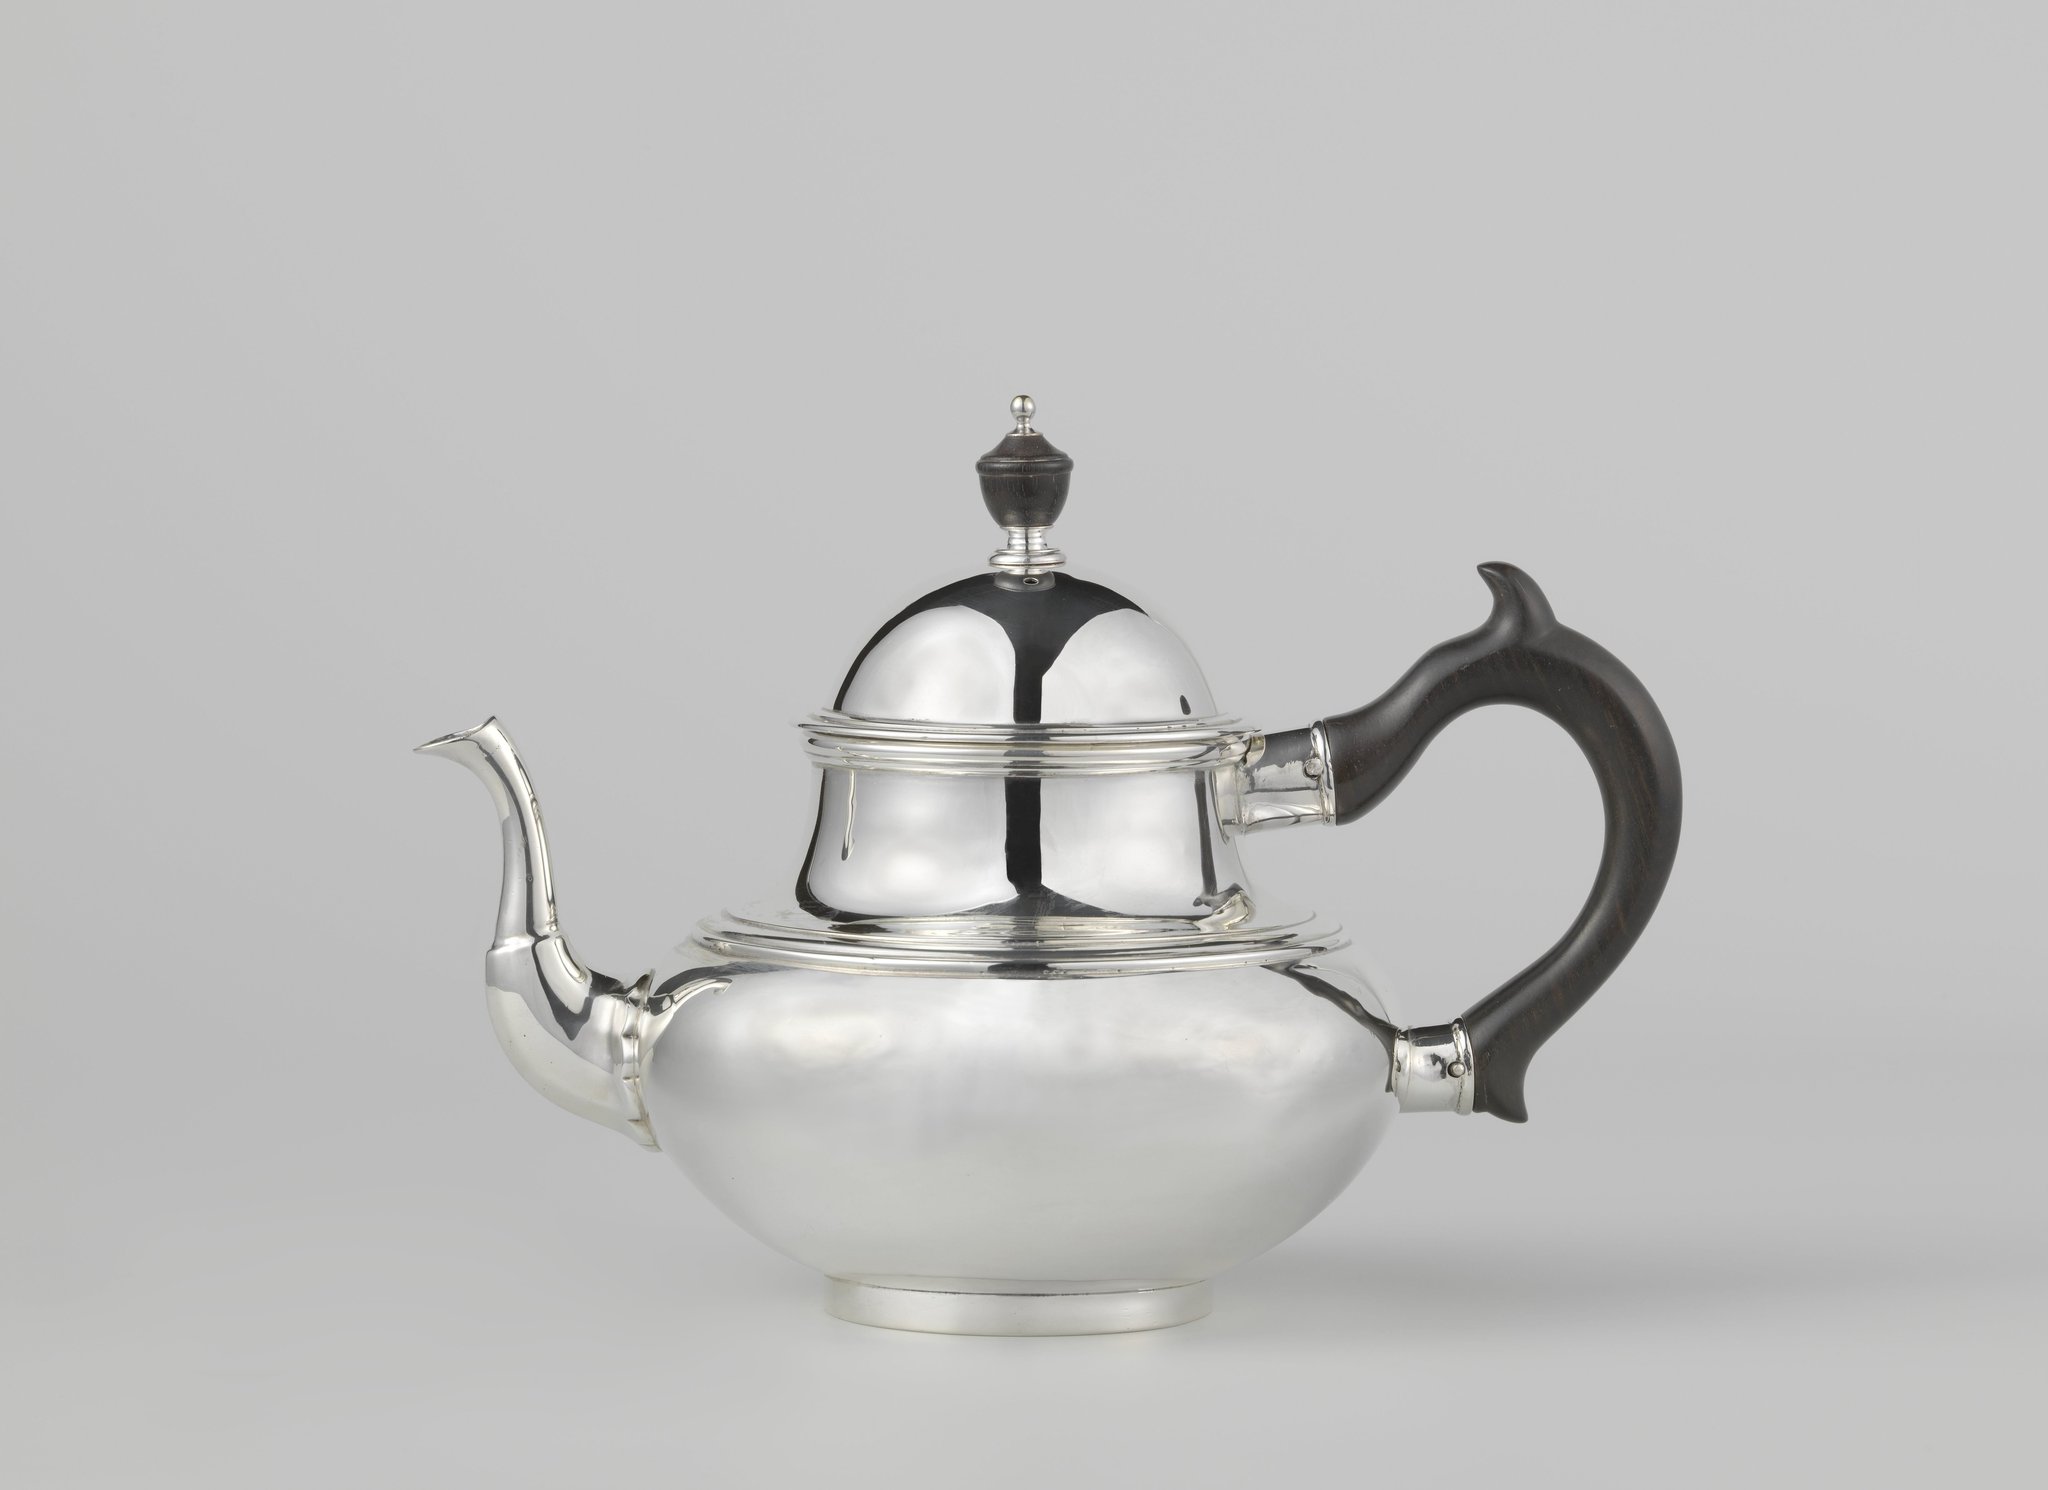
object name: teapot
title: Theepot van zilver met handvat en dekselknop van ebbenhout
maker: hermanus montauban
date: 1727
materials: wood, silver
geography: gorinchem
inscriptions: mark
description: Teapot. Silver. Gorinchem, 1727, by Hermanus Montauban.